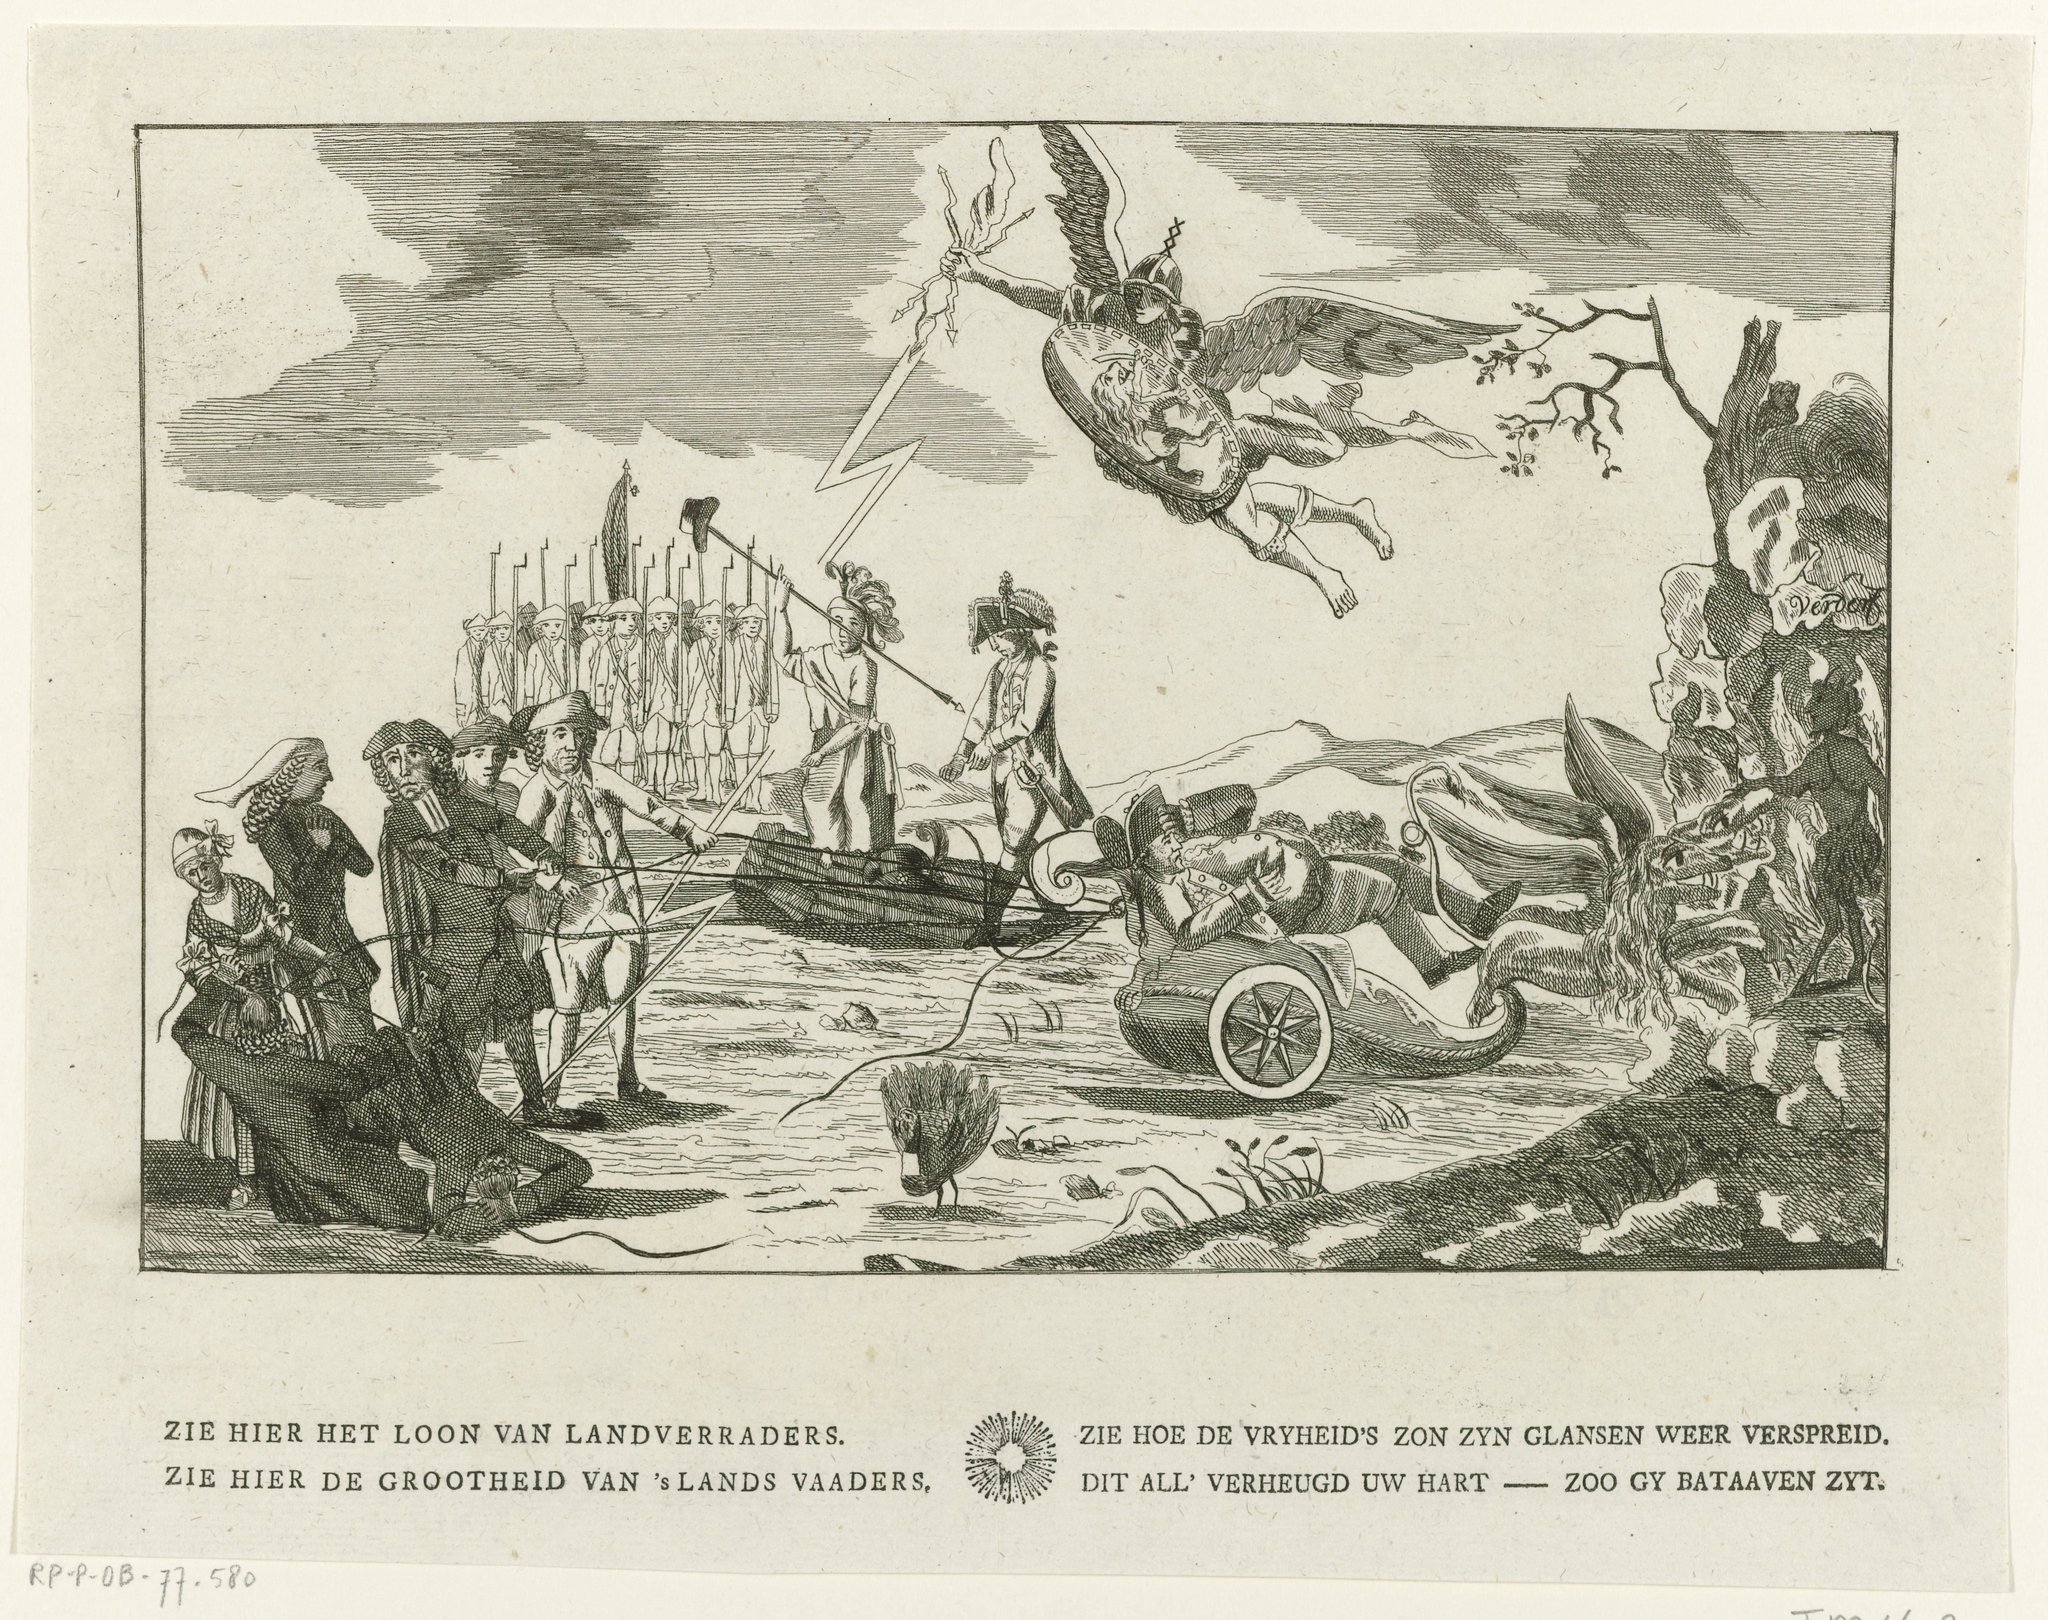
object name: cartoon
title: De hellevaart van een landverrader, 1784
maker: Anonymous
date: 1784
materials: paper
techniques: etching, letterpress printing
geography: northern netherlands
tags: the hague, william v (prince of orange), ludwig ernst von braunschweig-wolfenbüttel, rotterdam, petrus hofstede, utrecht, kaat mossel, political caricatures and satires, patriots (1780-1795)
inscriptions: collector's mark: Lugt 2228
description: Spotprent op het vertrek van de hertog van Brunswijk uit Nederland, 14 oktober 1784. De hertog wordt op een kar door Cerberus naar de hel getrokken. Petrus Hofstede, Kaat Mossel, Elie Luzac, R.M. van Goens en Pieter Joosten proberen de aftocht van de kar tegen de houden, maar worden dooor bliksemschichten hiervan weerhouden. Op de achtergrond de Nederlandse Vrijheid, prins Willem V en een vrijkorps. Met vierregelig onderschrift. Bij de prent behoren een verklaring en een blad met een vers.